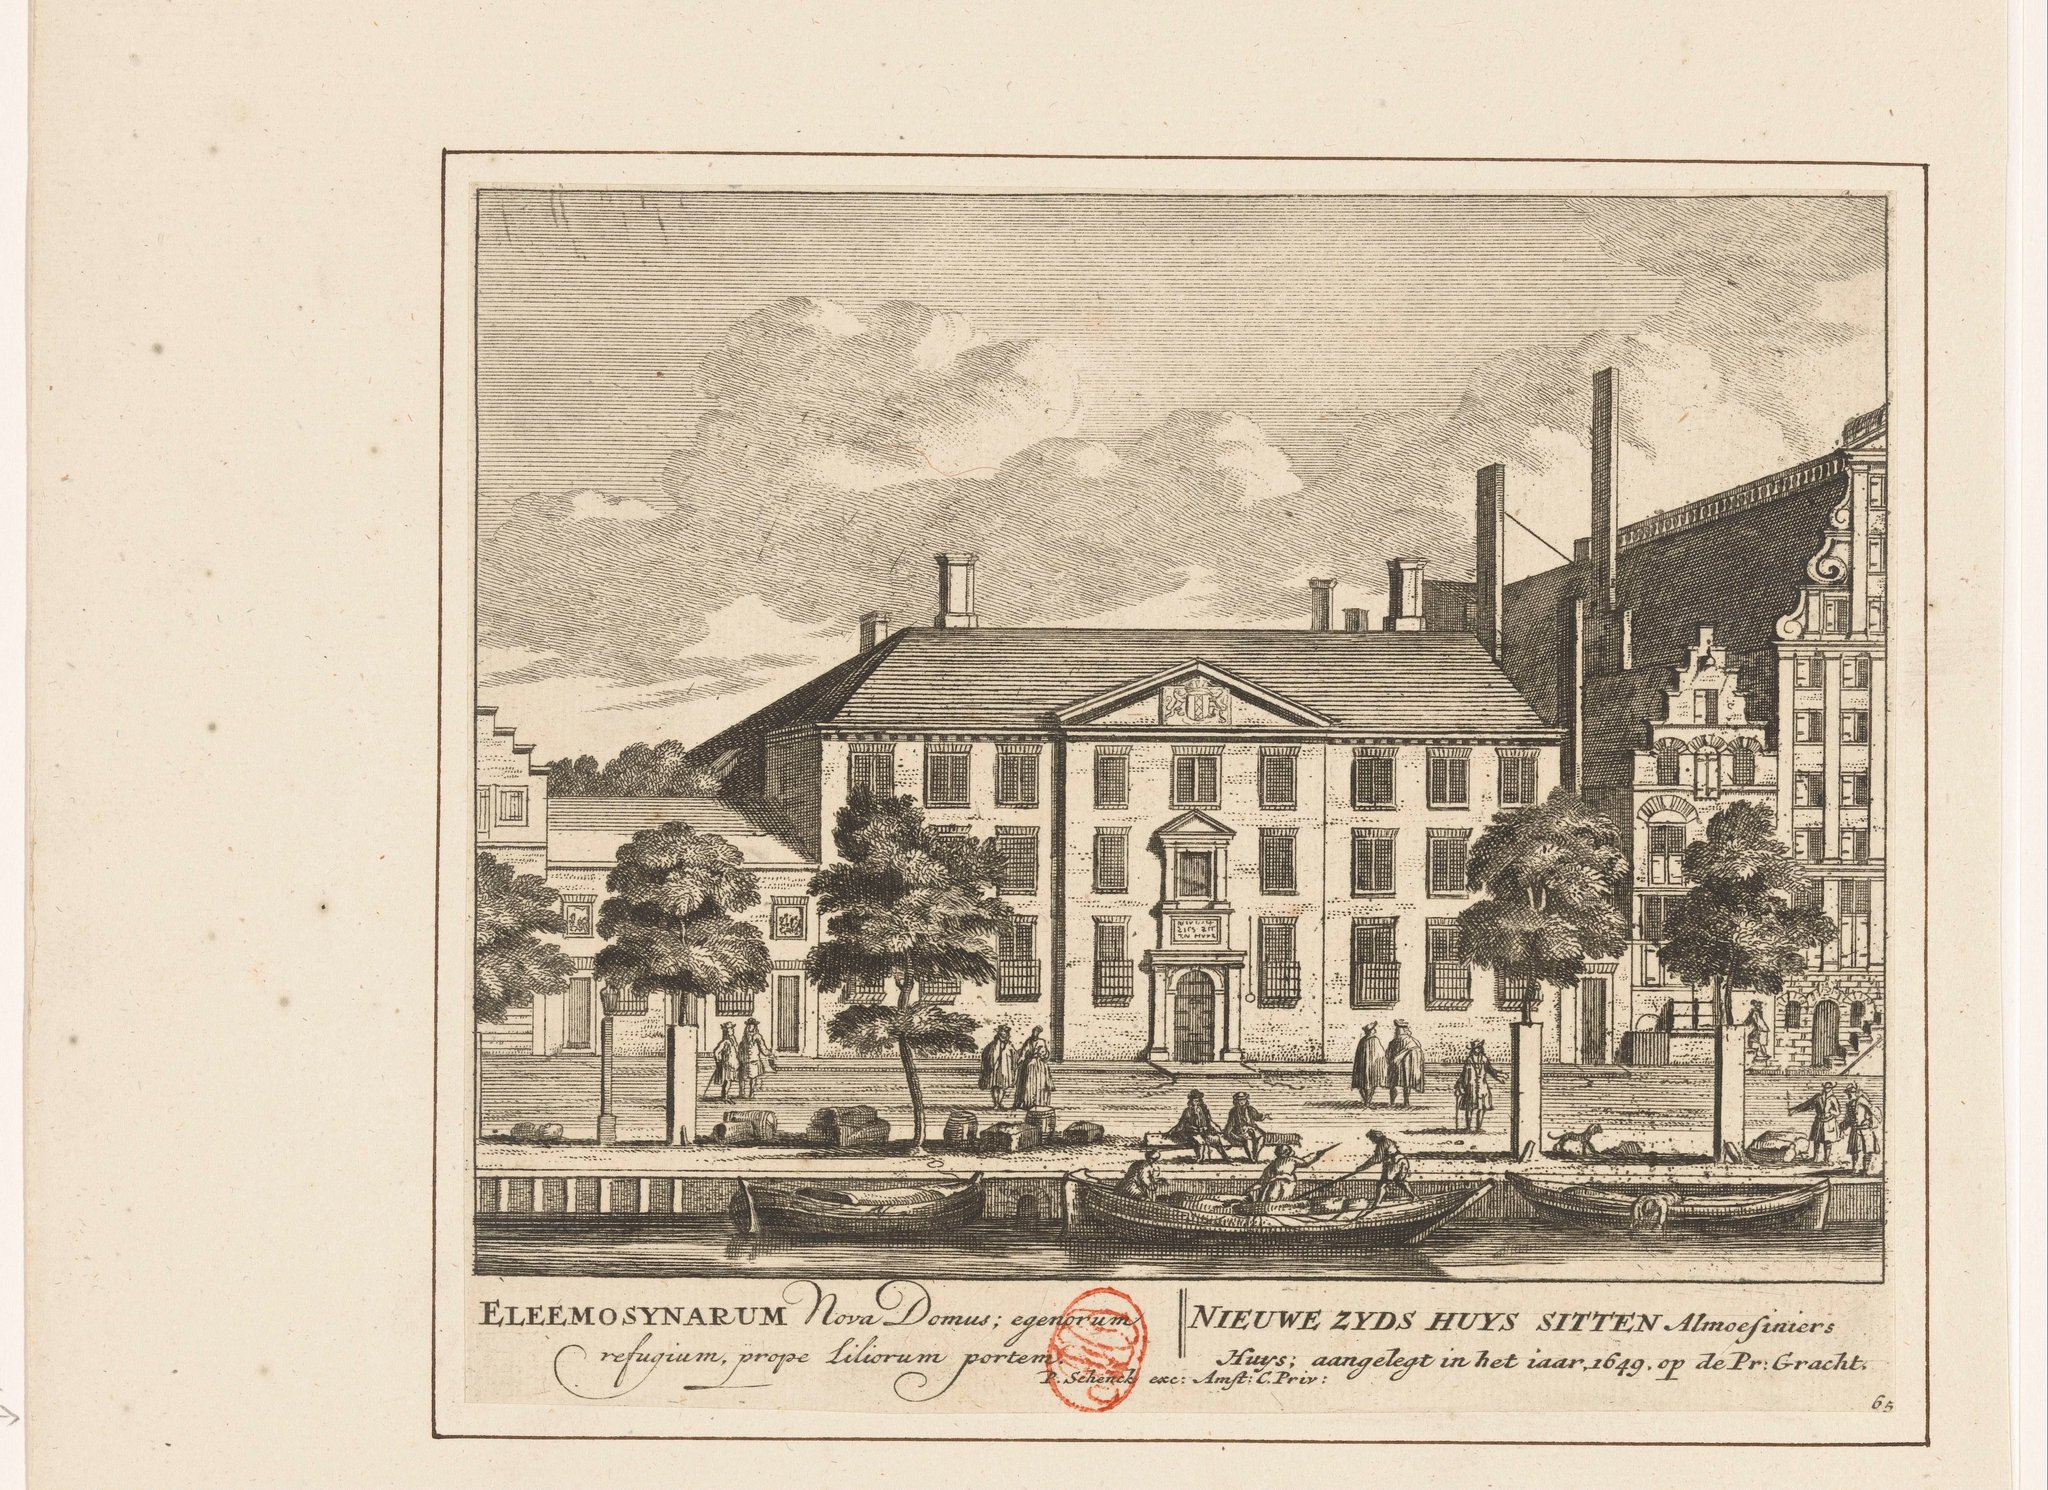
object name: print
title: Eleemosynarum Nova Domus; egenorum refugium liliorum portem / Nieuwe zyds huys sitten Almoesiniers Huys; aangelegt in het iaar 1649, op de Pr: Gracht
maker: Anonymous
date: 1710-1711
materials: paper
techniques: engraving, etching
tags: public welfare, poorhouse, canals, waters (in city) (+ city(-scape) with figures, staffage), street (+ city(-scape) with figures, staffage)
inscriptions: collector's mark: Lugt 195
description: Huidige staat van prent ook gebruikt in: 100 Afbeeldinge der voornaamste gebouwen van Amsterdam. Amsterdam, Pieter Schenk (I), s.a. [1710-1711]. En in: 100 Afbeeldinge der voornaamste gebouwen van Amsterdam. Amsterdam, Barent Greve, s.a. [1757-1766].* *In de tweede uitgave, uitgegeven door Barent Greve, is alleen de titelprent aangepast. De overige prenten zijn onveranderd gebleven.